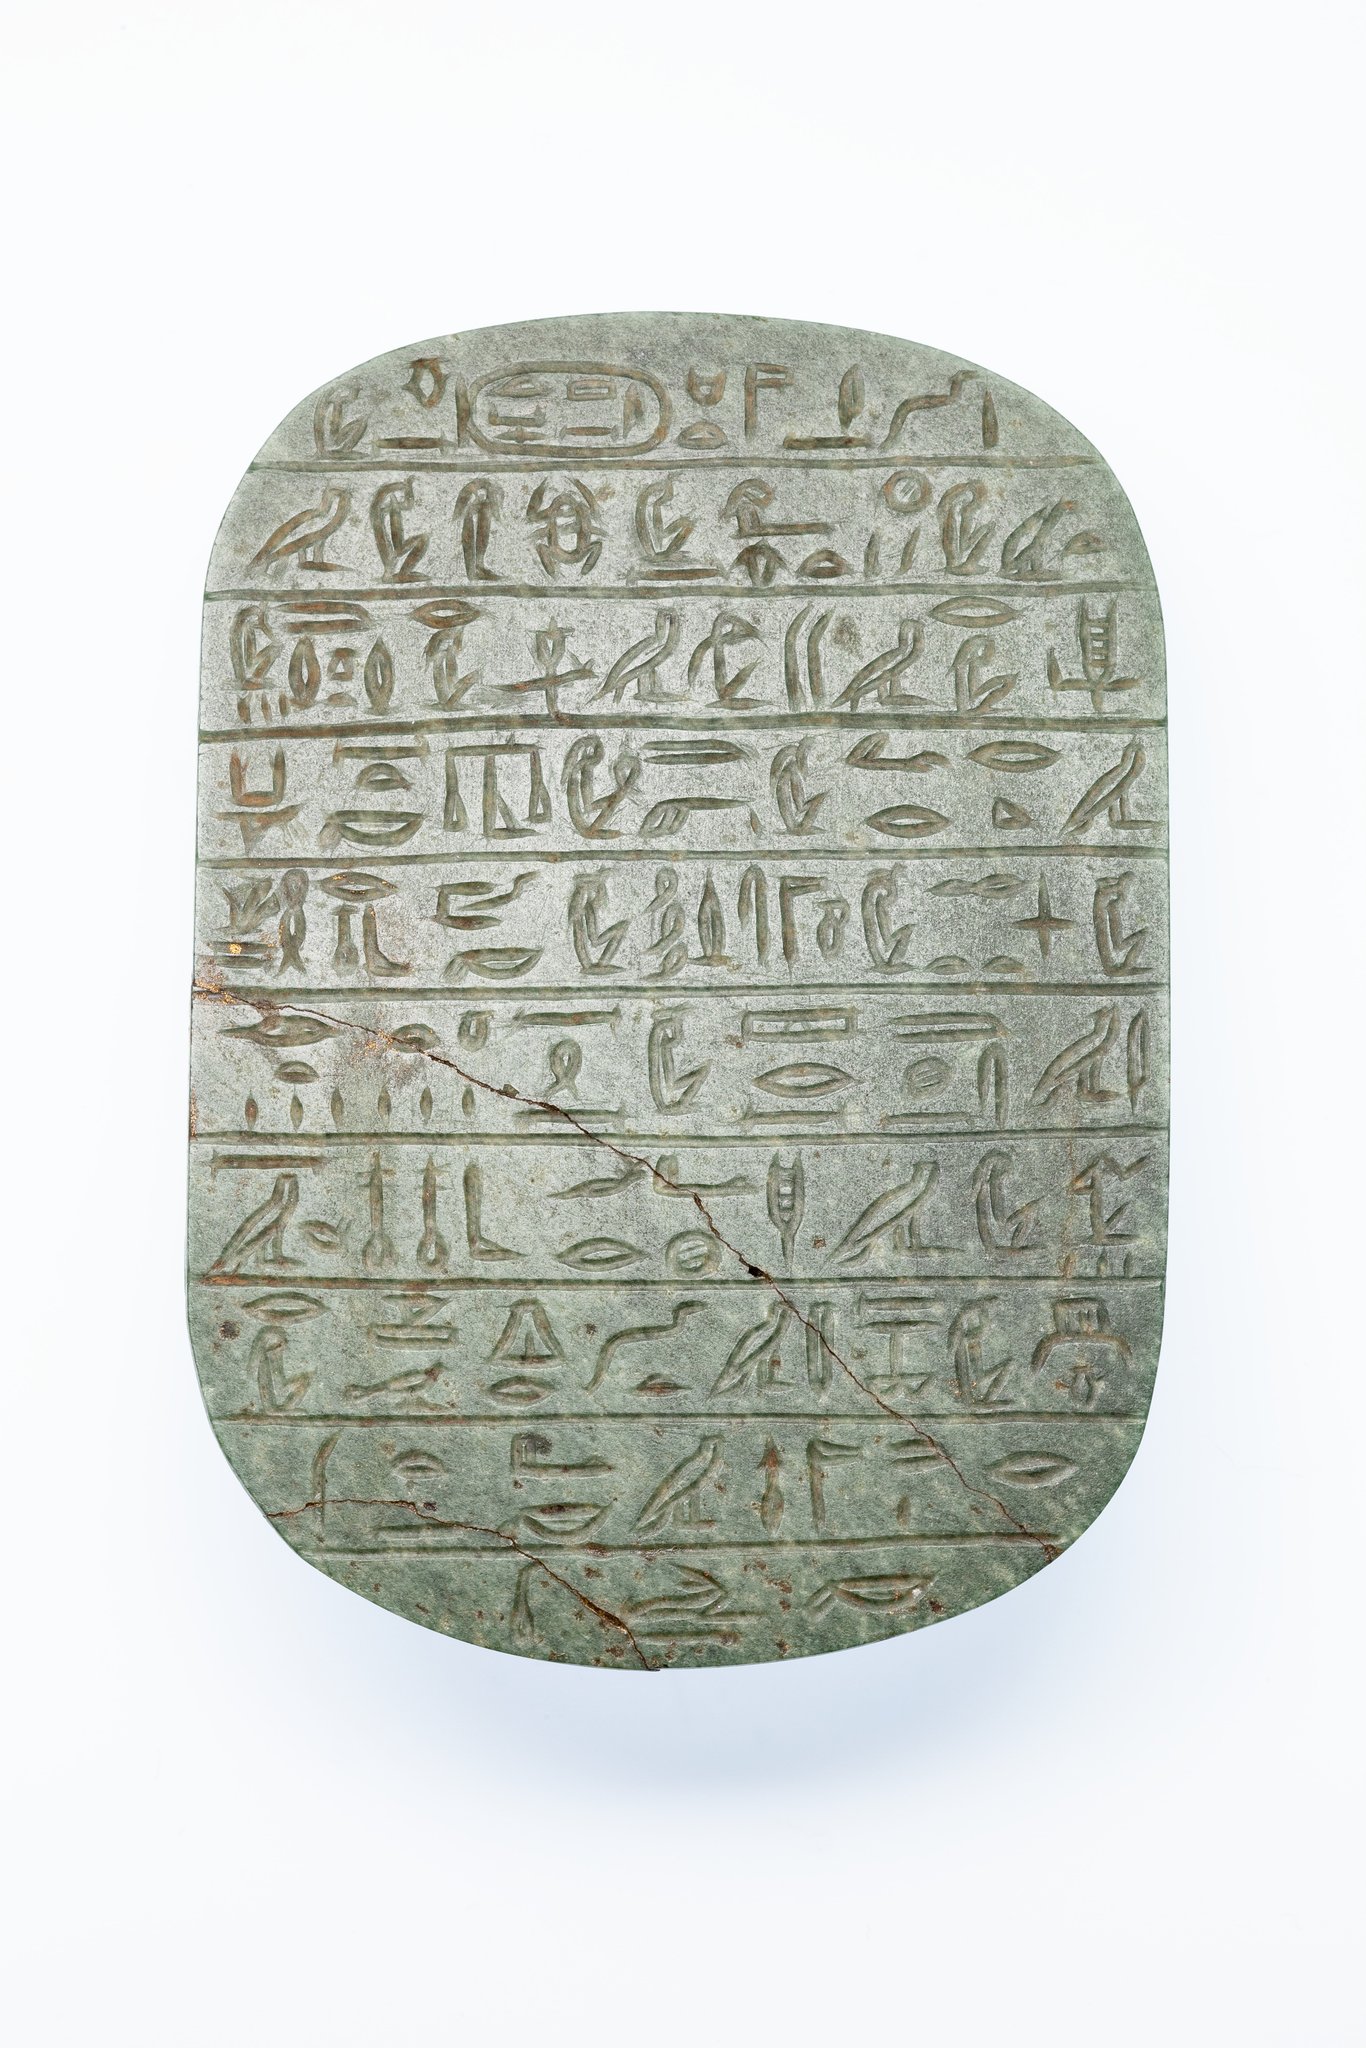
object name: heart scarab, amenirdis i, kashta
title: Heart Scarab with the Cartouche of Amenirdis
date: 760-747 BCE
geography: egypt and sudan